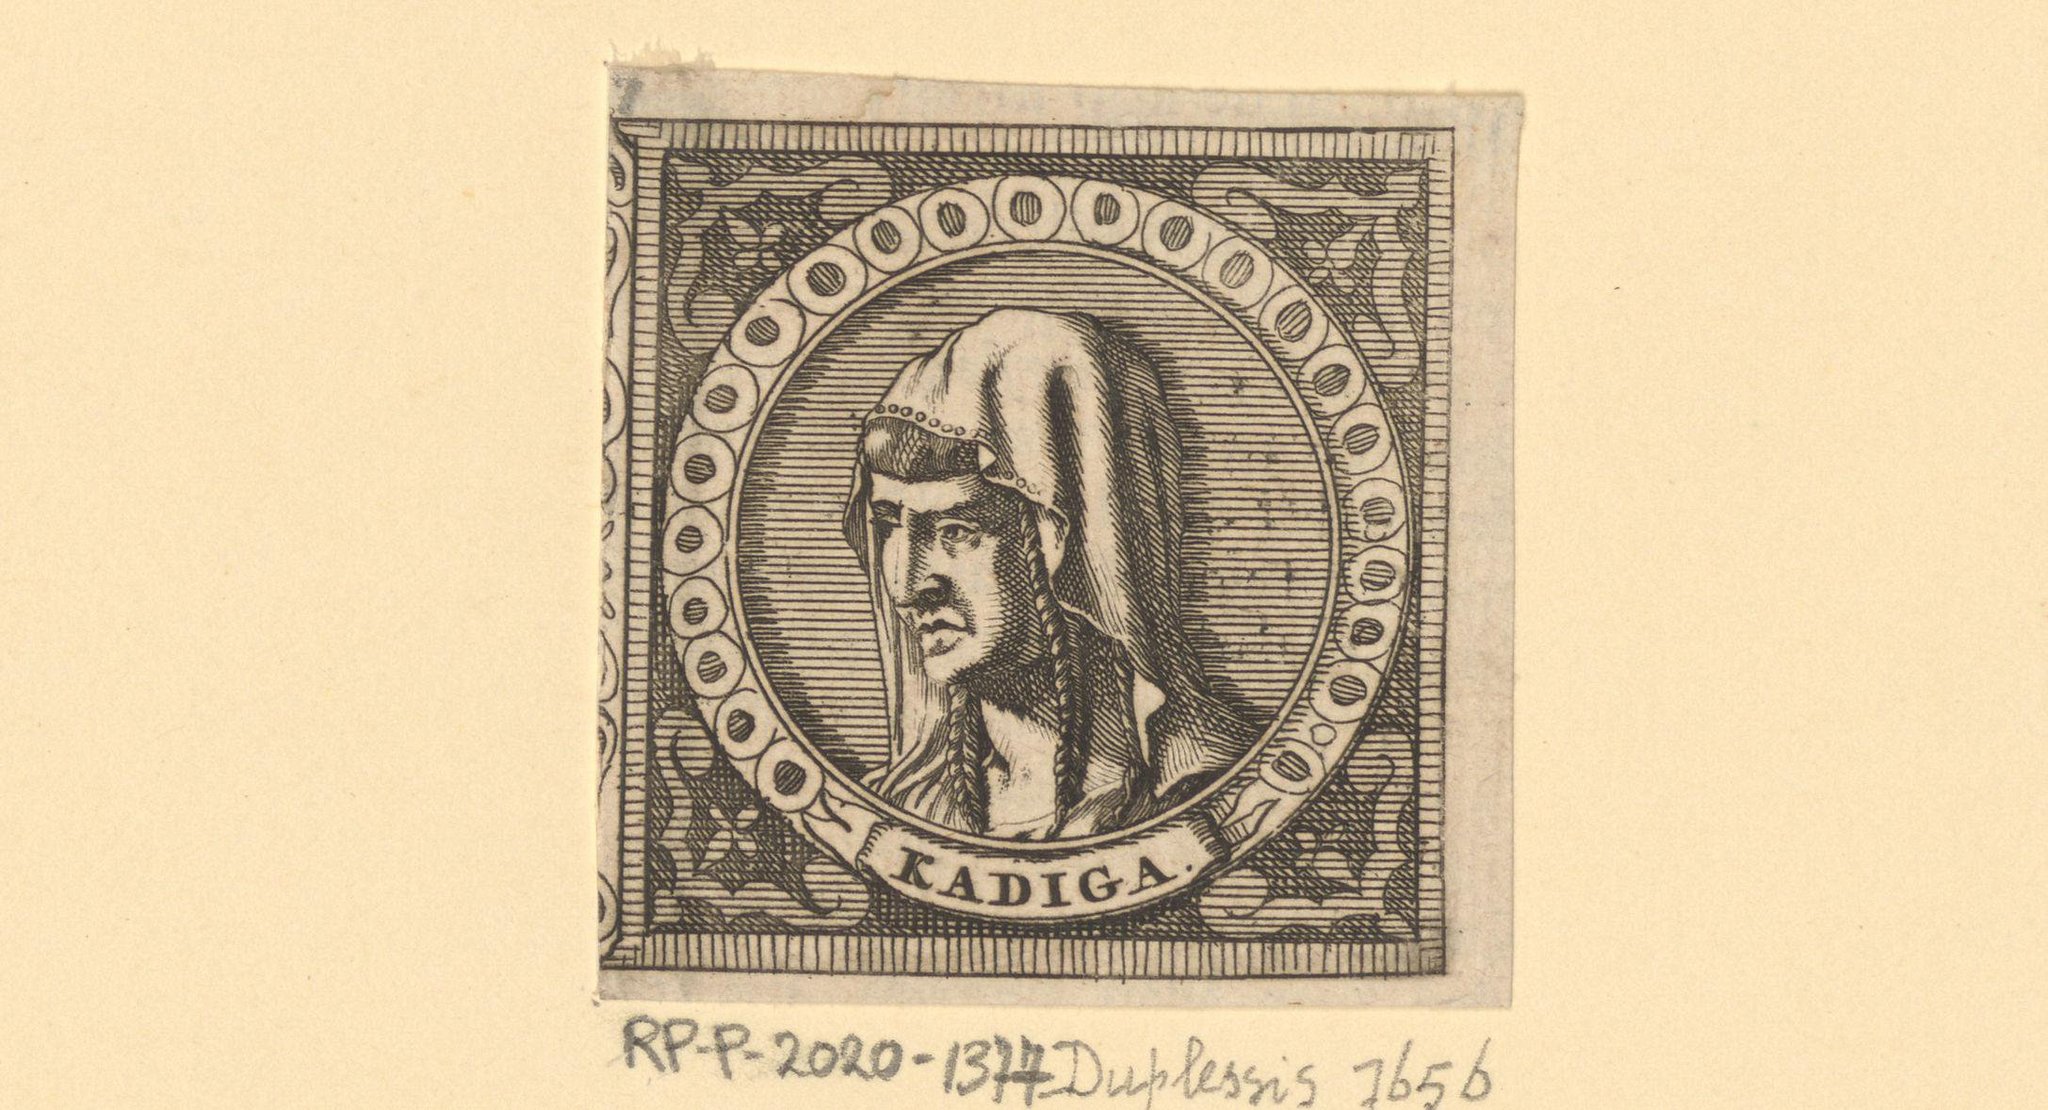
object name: book illustration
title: Portret van Khadija bint Khuwaylid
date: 1730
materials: paper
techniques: etching, letterpress printing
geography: leiden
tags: historical persons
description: Prent uit: Goeree, Willem. De kerklyke en weereldlyke historien, uyt d'aal-ouwde aardbeschryving en uytgezogte gedenk-penningen opgehelderd (...). Leiden: Johannes van Abkoude, 1730. Prent mogelijk ook gebruikt in de eerdere editie uit 1705.